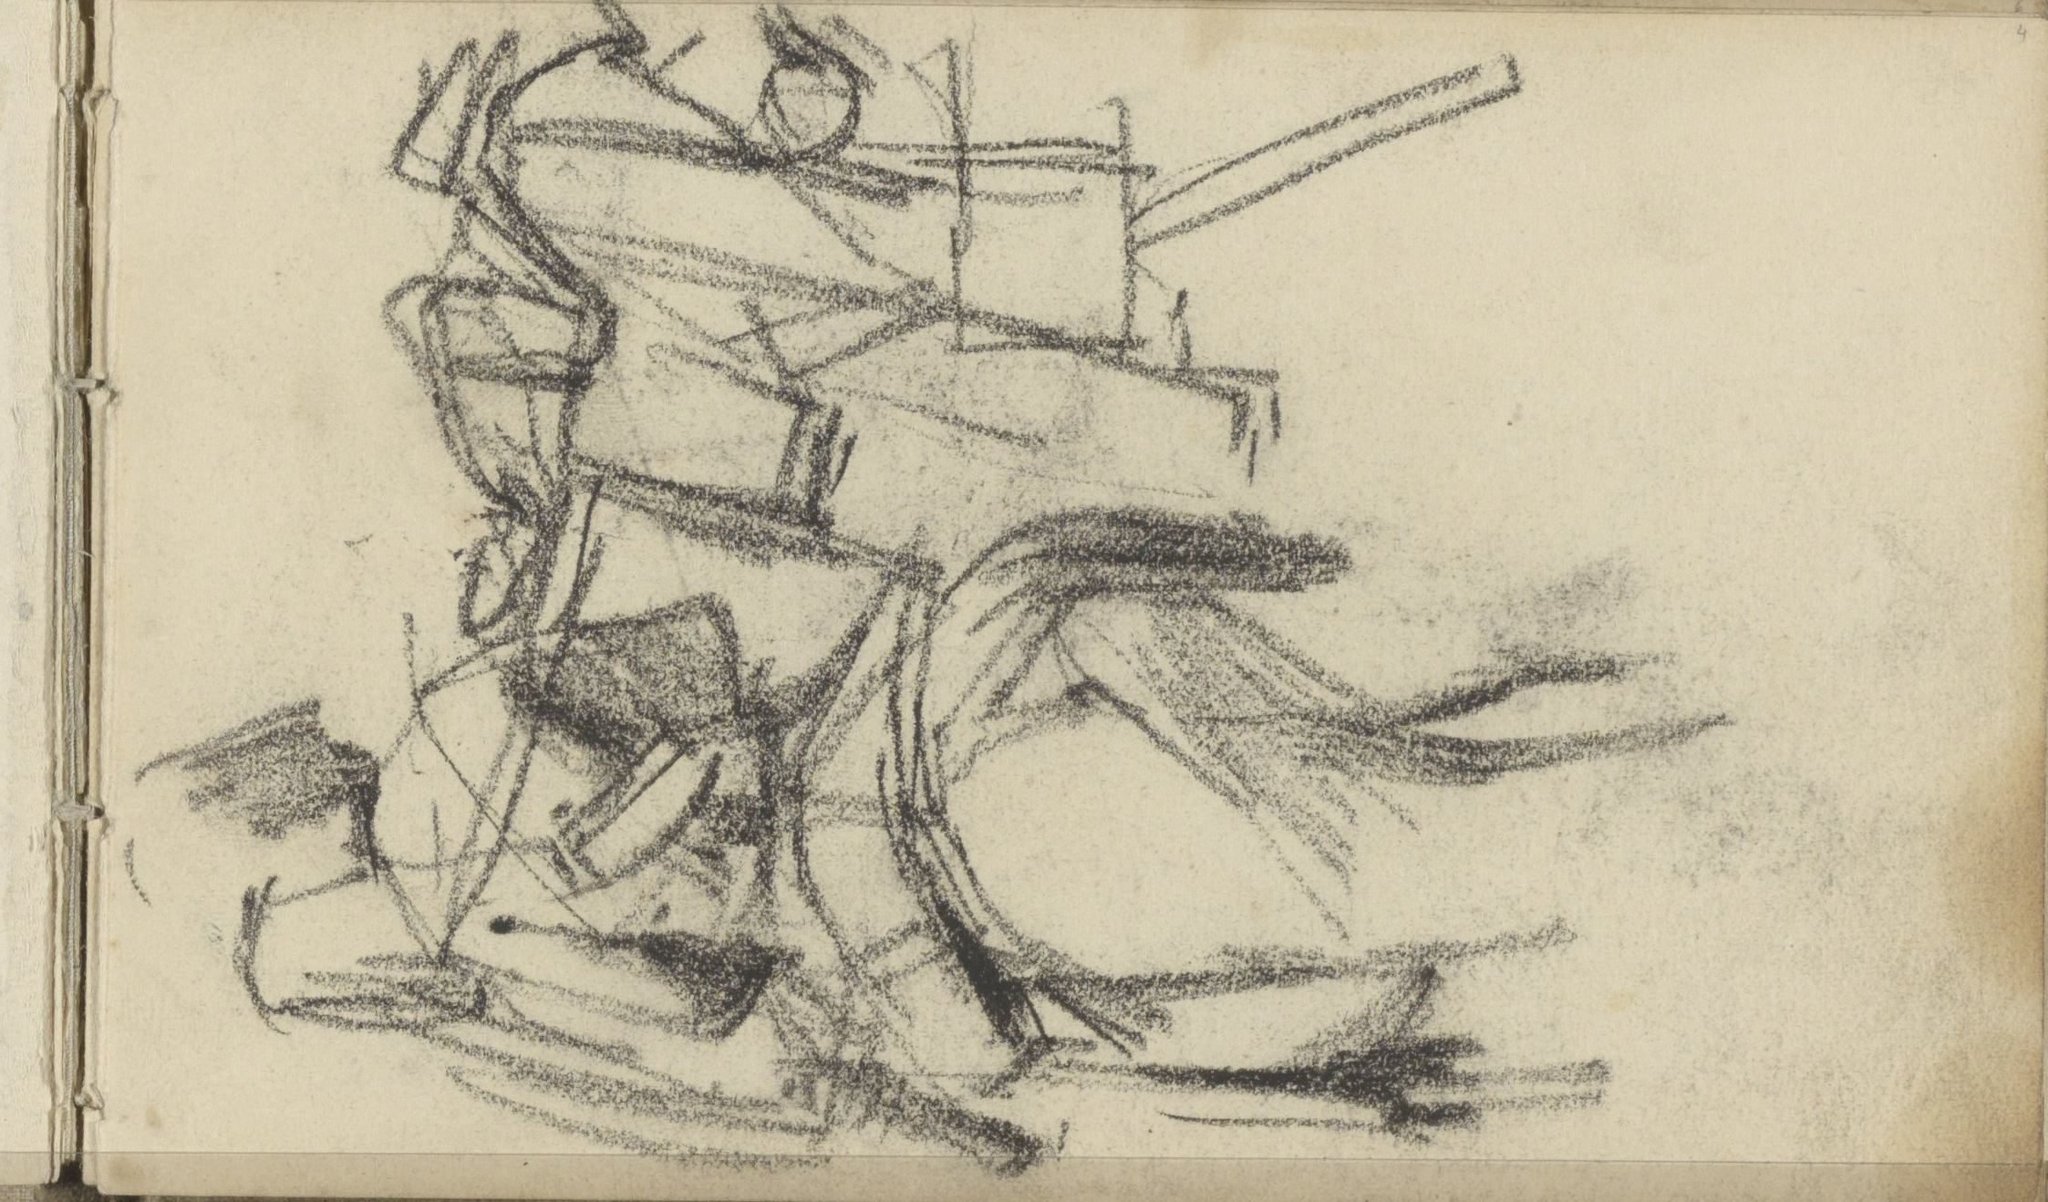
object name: sketchbook leaf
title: Artillerist te paard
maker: george hendrik breitner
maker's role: draughtsman, painter, print maker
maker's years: 1857-1923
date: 1884-1886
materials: chalk, paper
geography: the hague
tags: land forces (+ artillery), horse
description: Pagina 4 uit een schetsboek met 35 bladen.